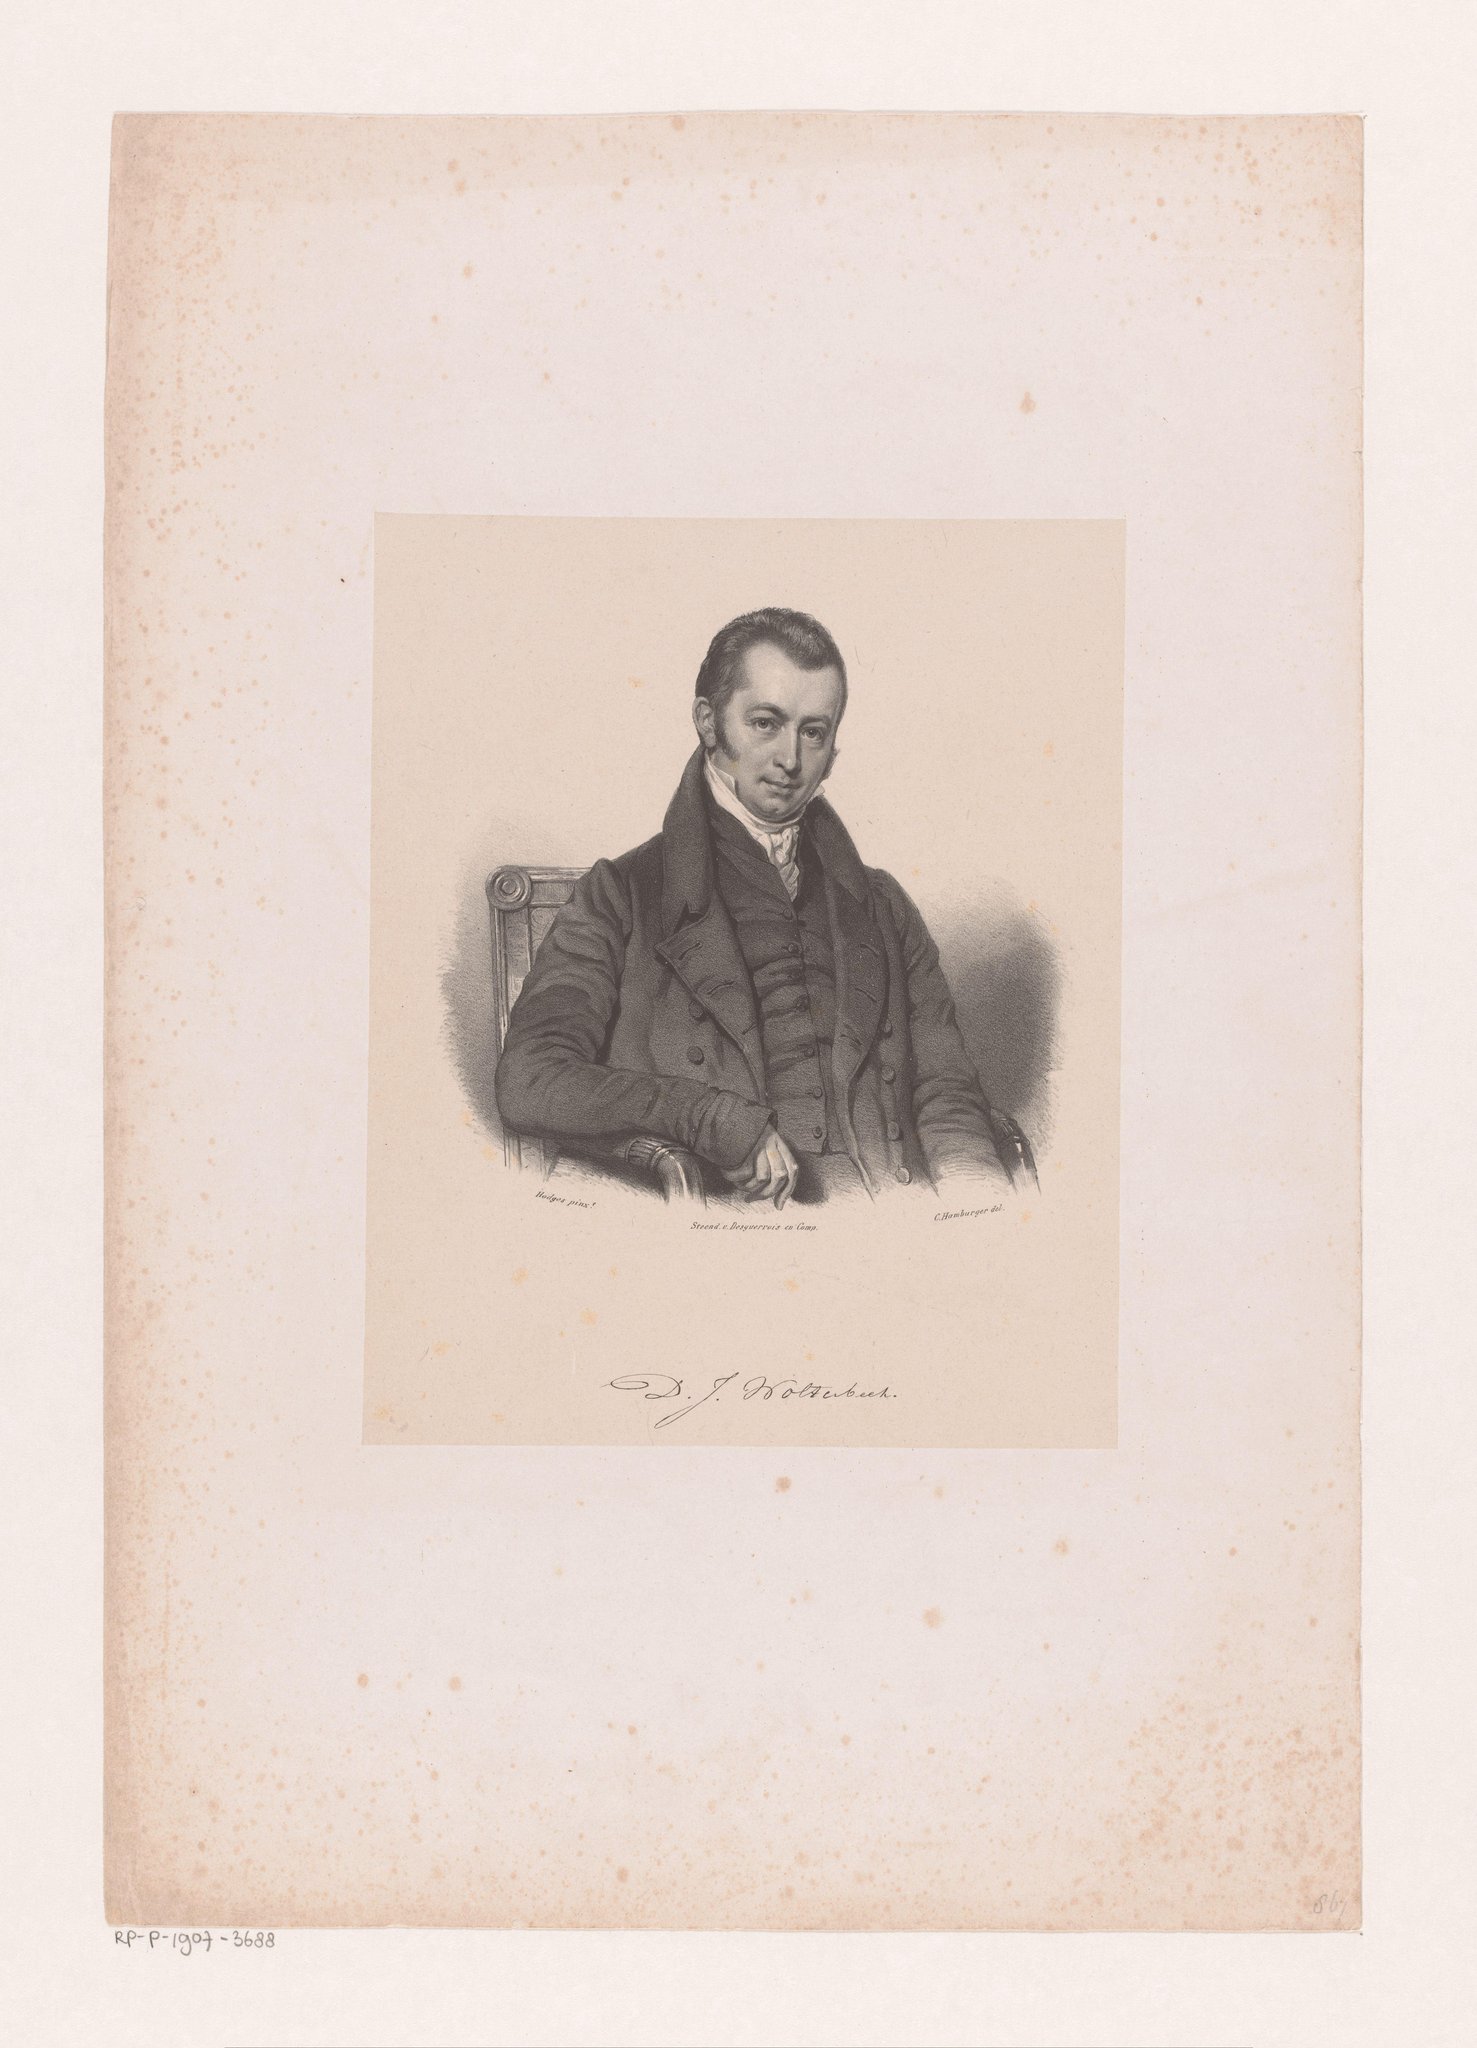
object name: print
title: Portret van Dirk Jacob Wolterbeek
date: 1819-1891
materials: paper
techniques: lithograph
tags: historical persons (+ (full) bust portrait)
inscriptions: collector's mark: Lugt 2228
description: Onder het portret de signatuur van de geportretteerde.